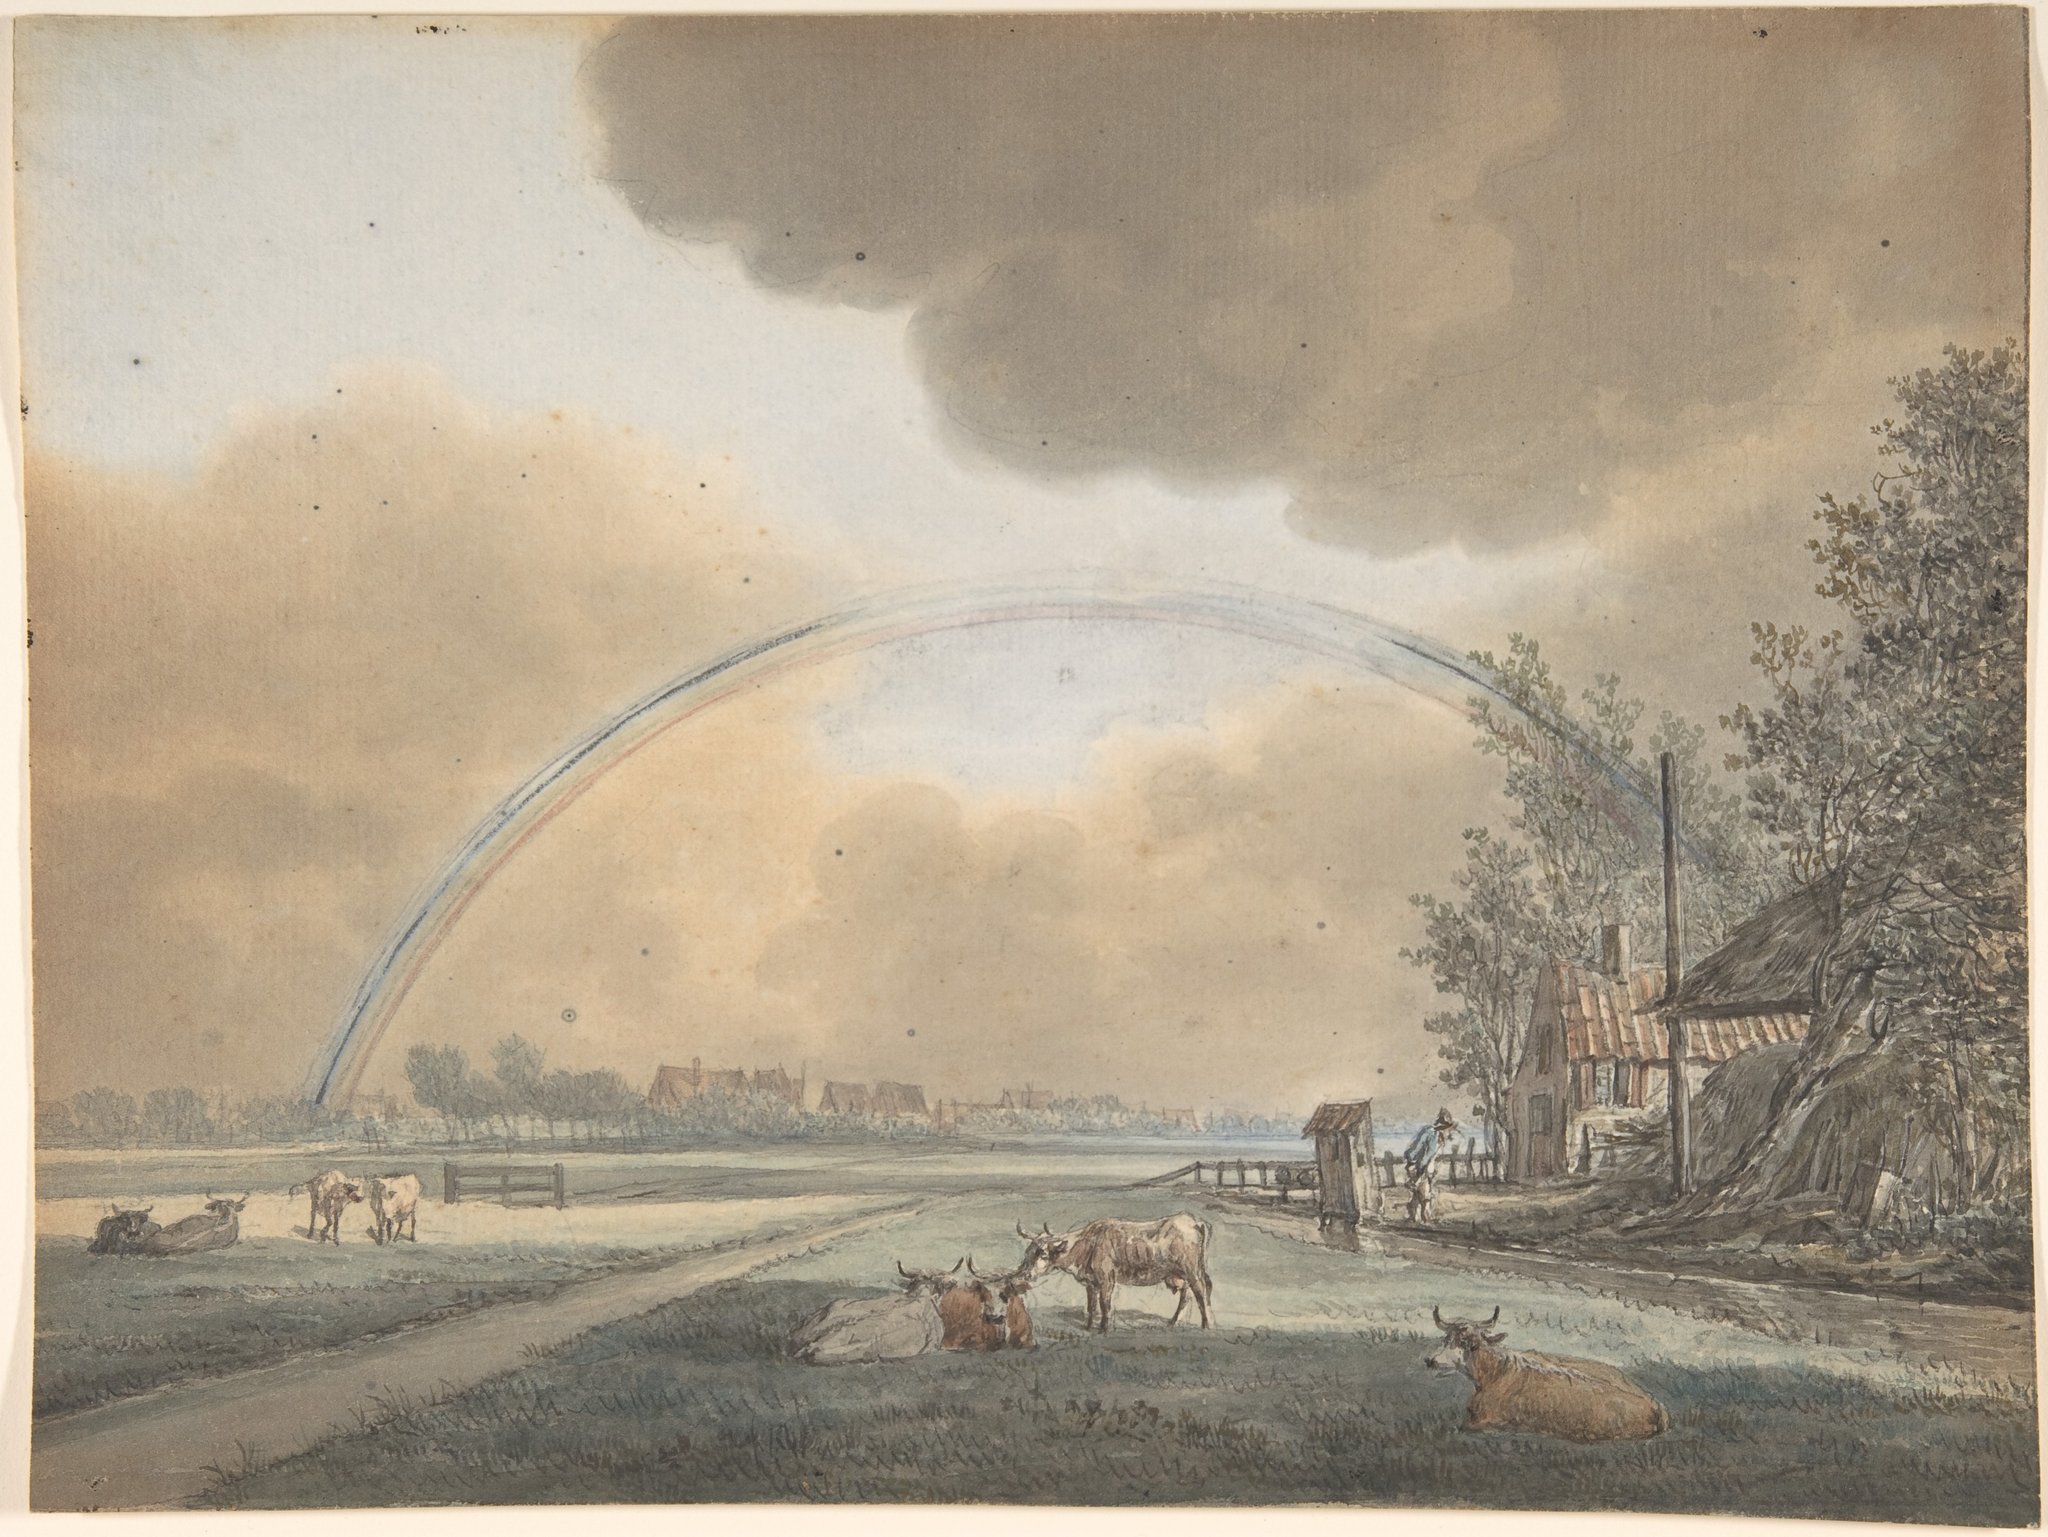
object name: drawing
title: Landscape with a Rainbow over a Farmhouse and Distant Village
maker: vincent jansz. van der vinne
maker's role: draughtsman, print maker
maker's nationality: dutch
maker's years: 1736-1811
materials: chalk, watercolor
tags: villages,cows,landscapes,trees,rainbows